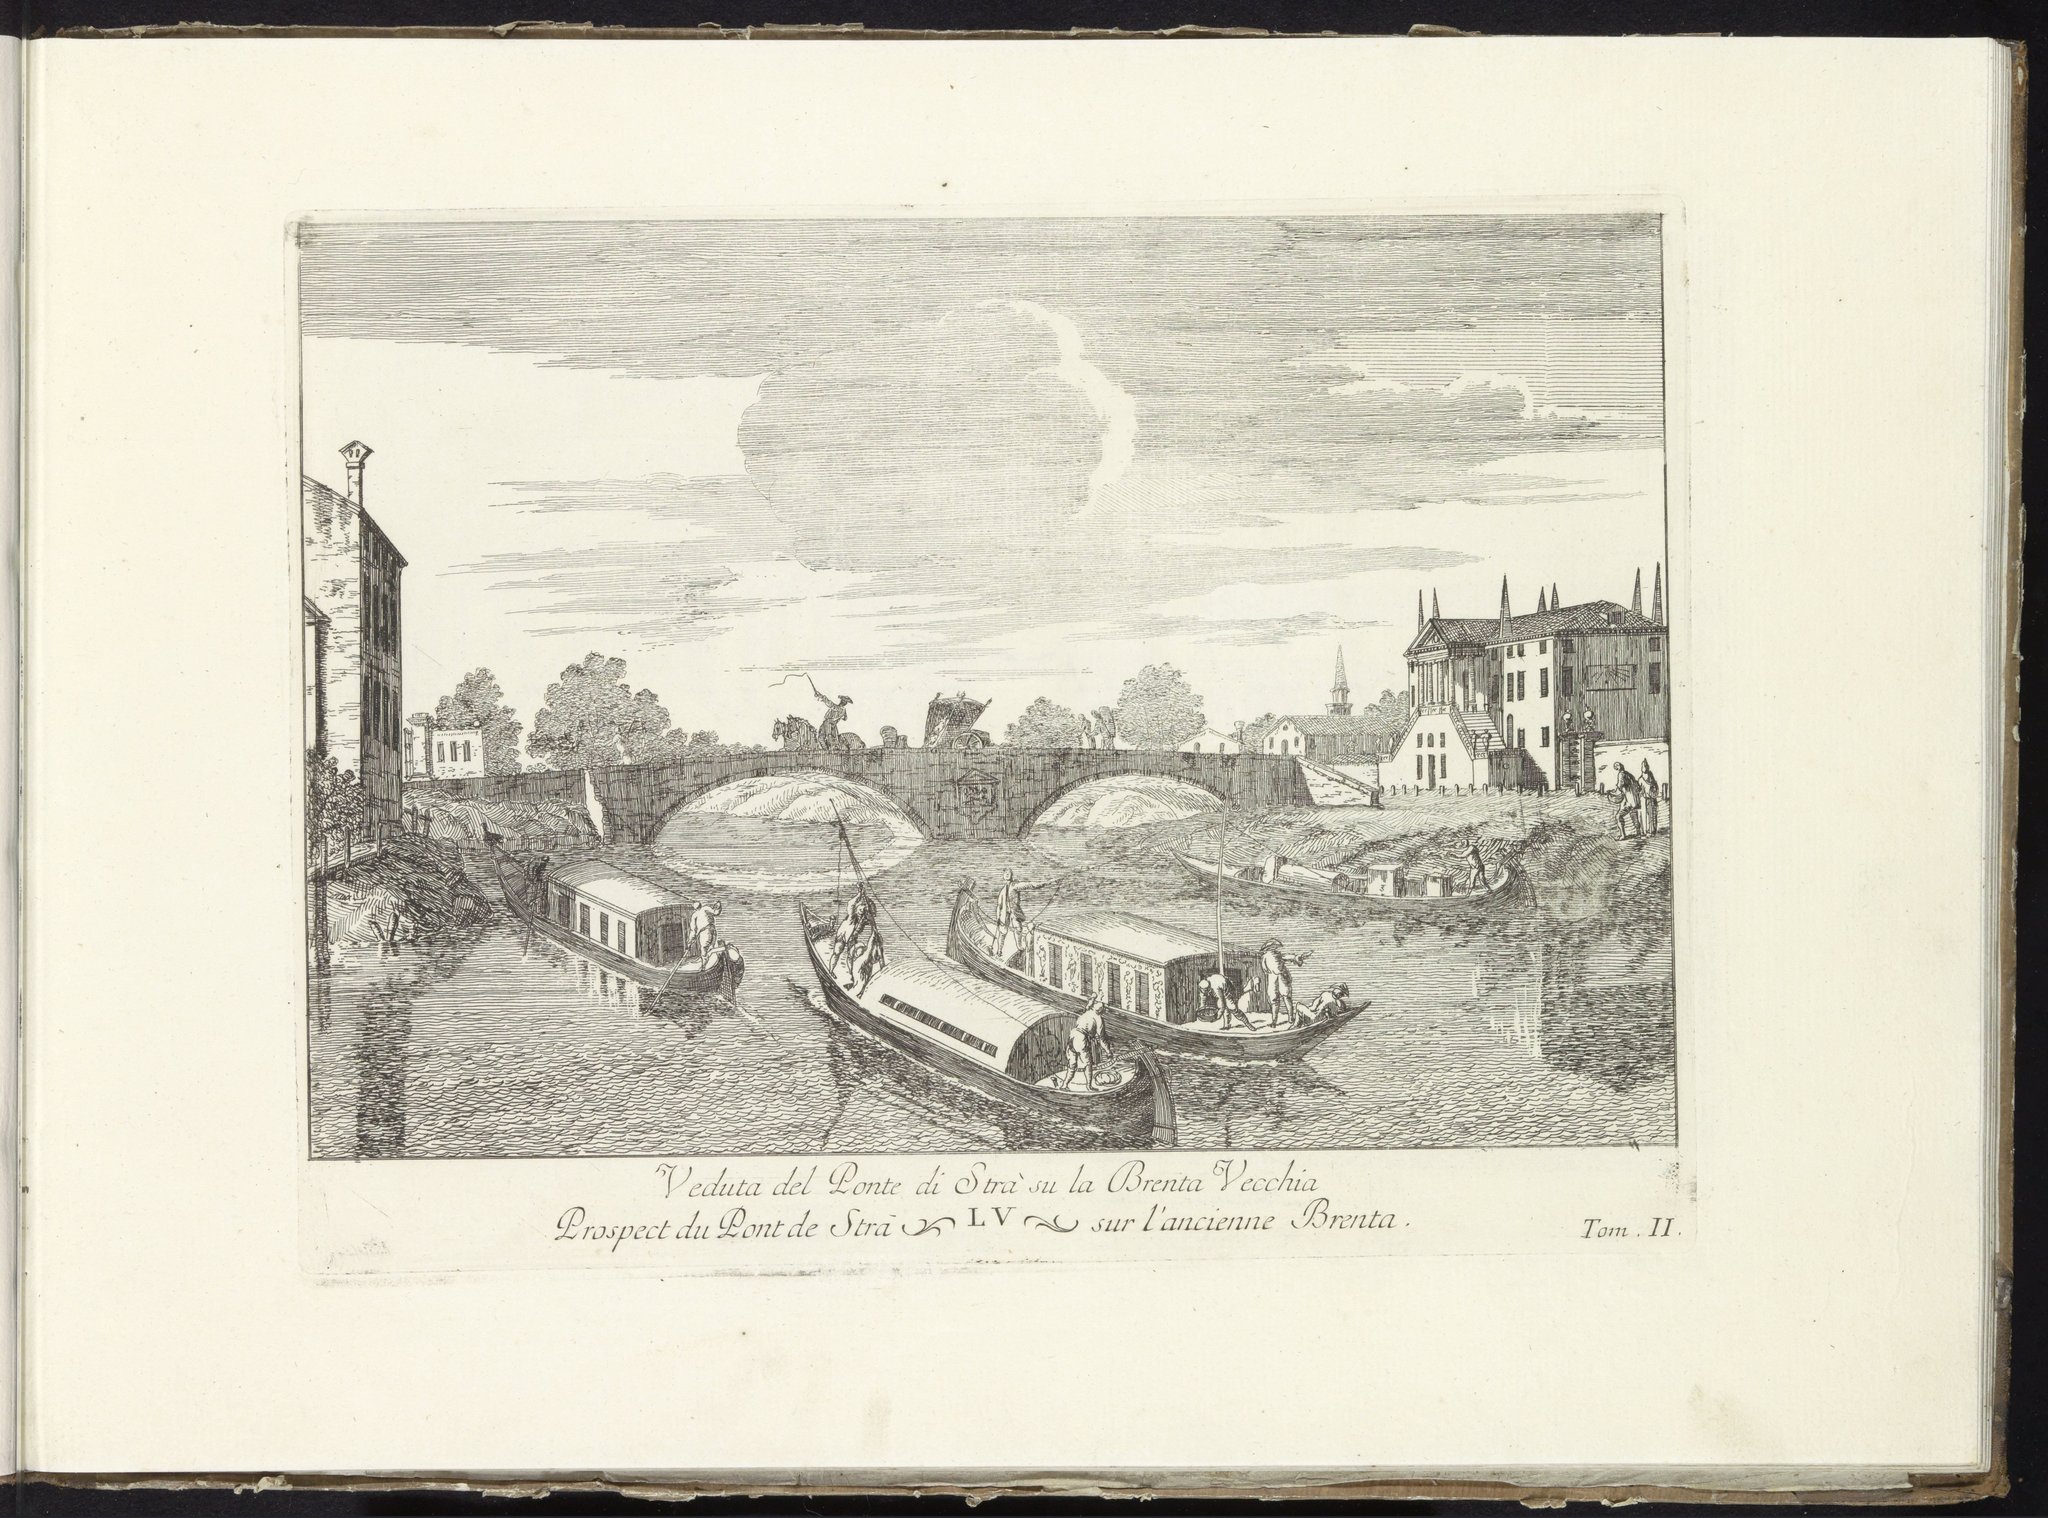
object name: print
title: Ponte di Strà over de rivier de Brenta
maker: giovanni francesco costa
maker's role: draughtsman, painter, print maker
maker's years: -1773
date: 1750-1760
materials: paper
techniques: etching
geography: venice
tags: river, tow-boat, towing-barge, bridge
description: Gezicht op de Ponte di Strà over de rivier de Brenta. Op de voorgrond liggen vier schuiten in het water voor de brug. Genummerd midden onder: LV en rechtsonder: Tom: II. Deze prent maakt deel uit van een album.